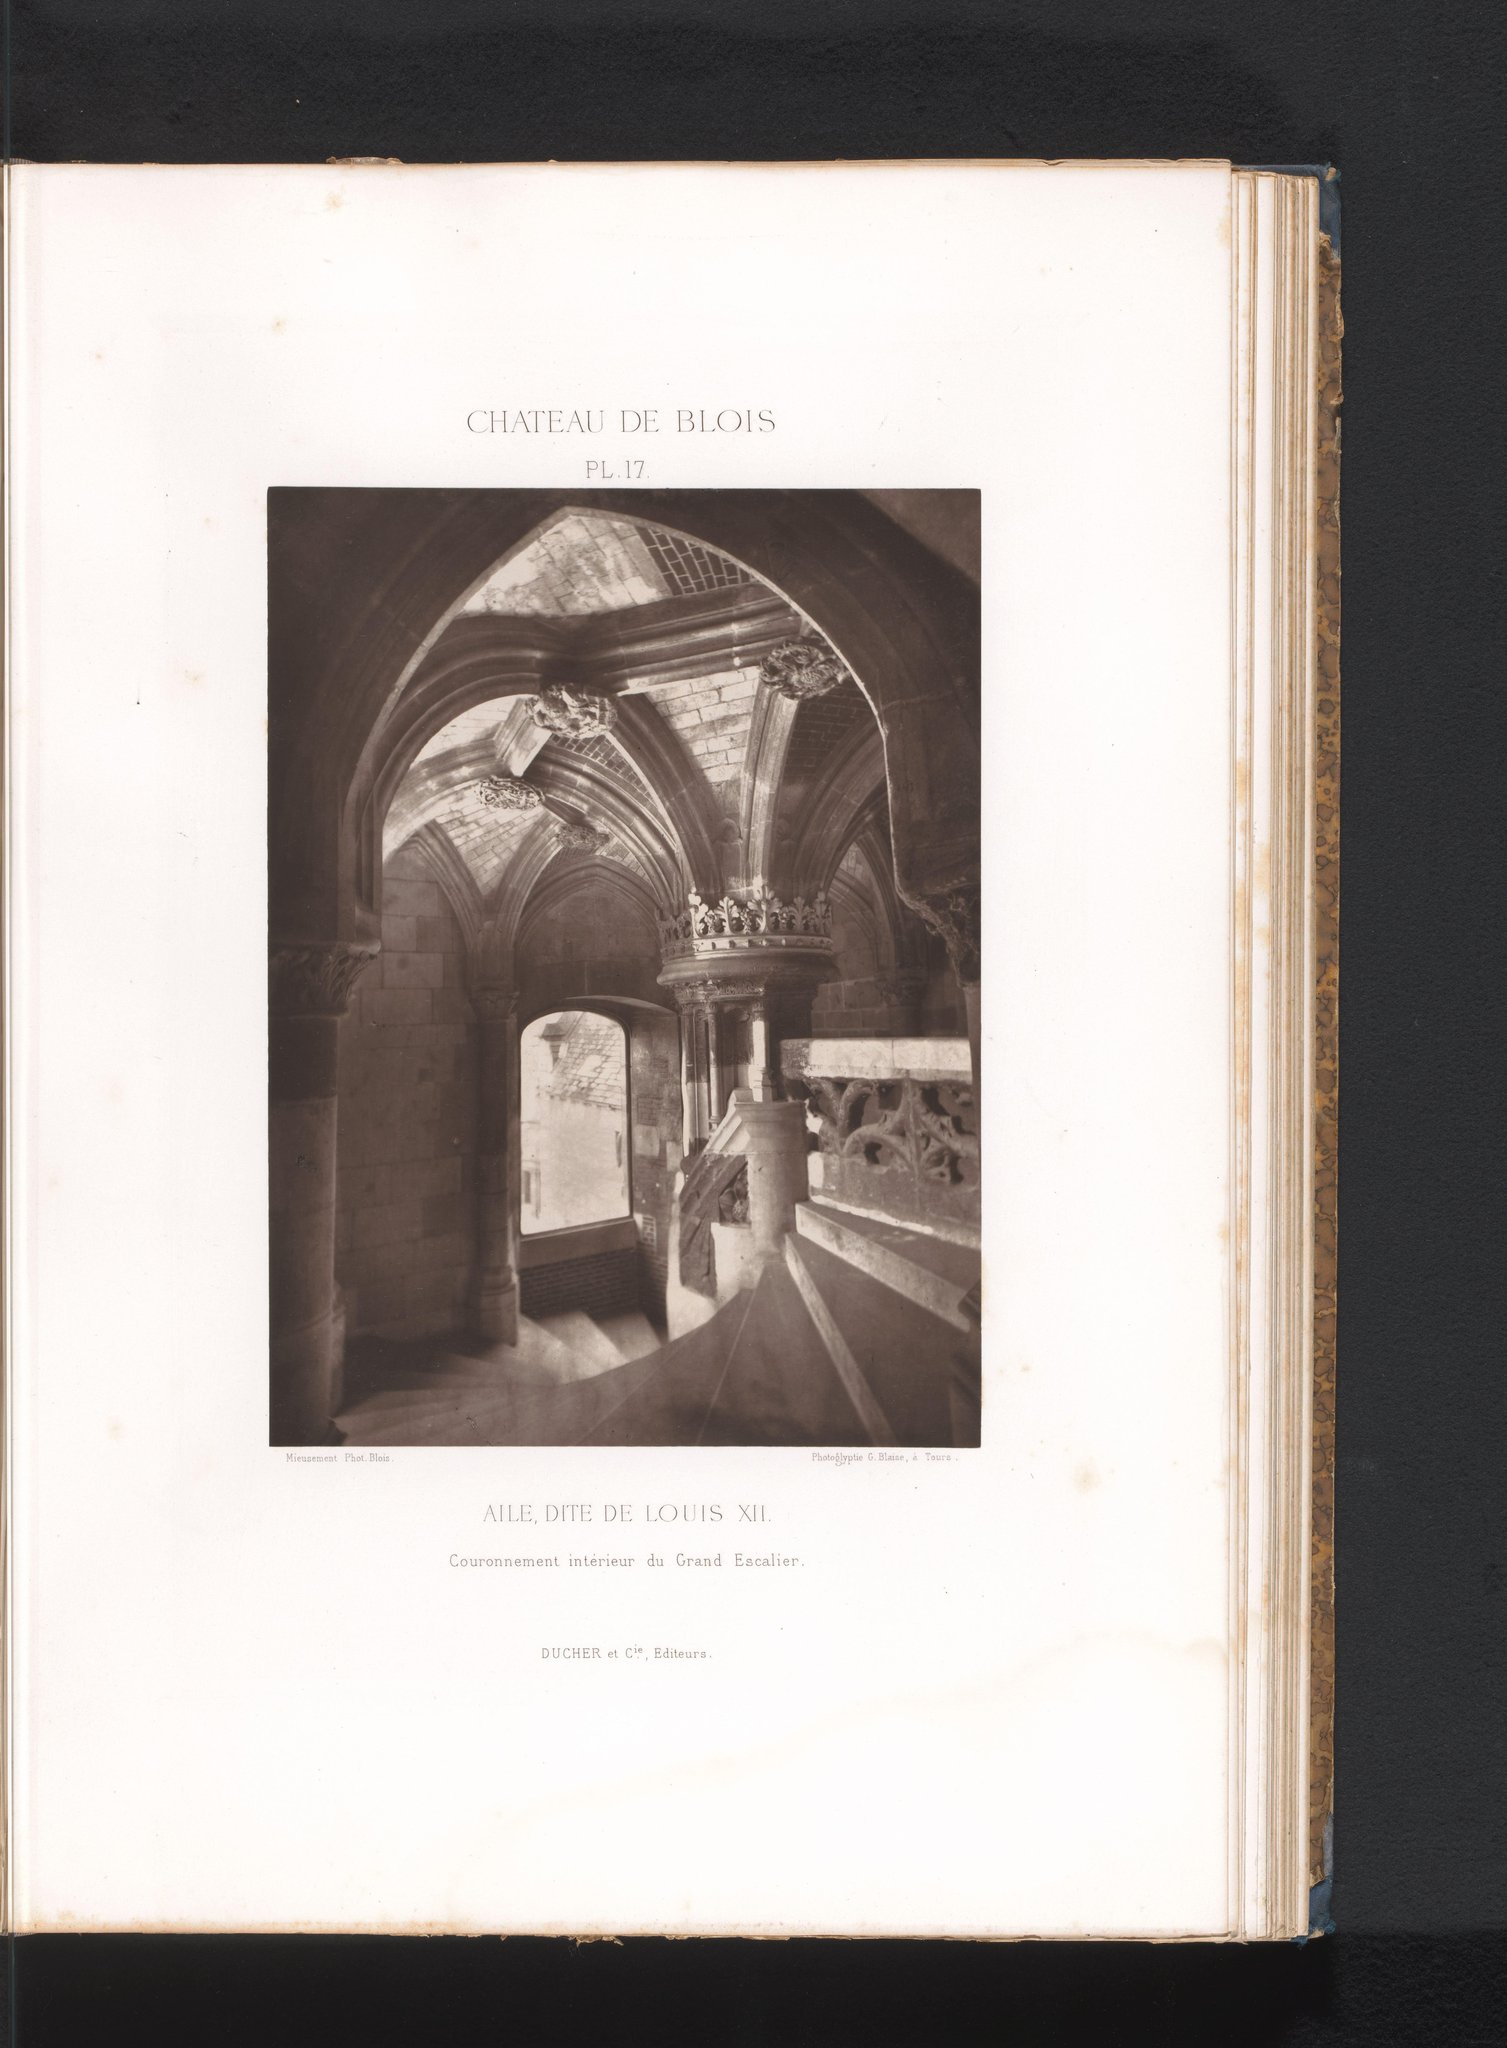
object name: page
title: Gezicht op de trap van de Lodewijk XII vleugel van het Kasteel van Blois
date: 1870-1875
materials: paper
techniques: woodburytype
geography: blois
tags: castle, staircase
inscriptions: number: ‘PL. 17.’